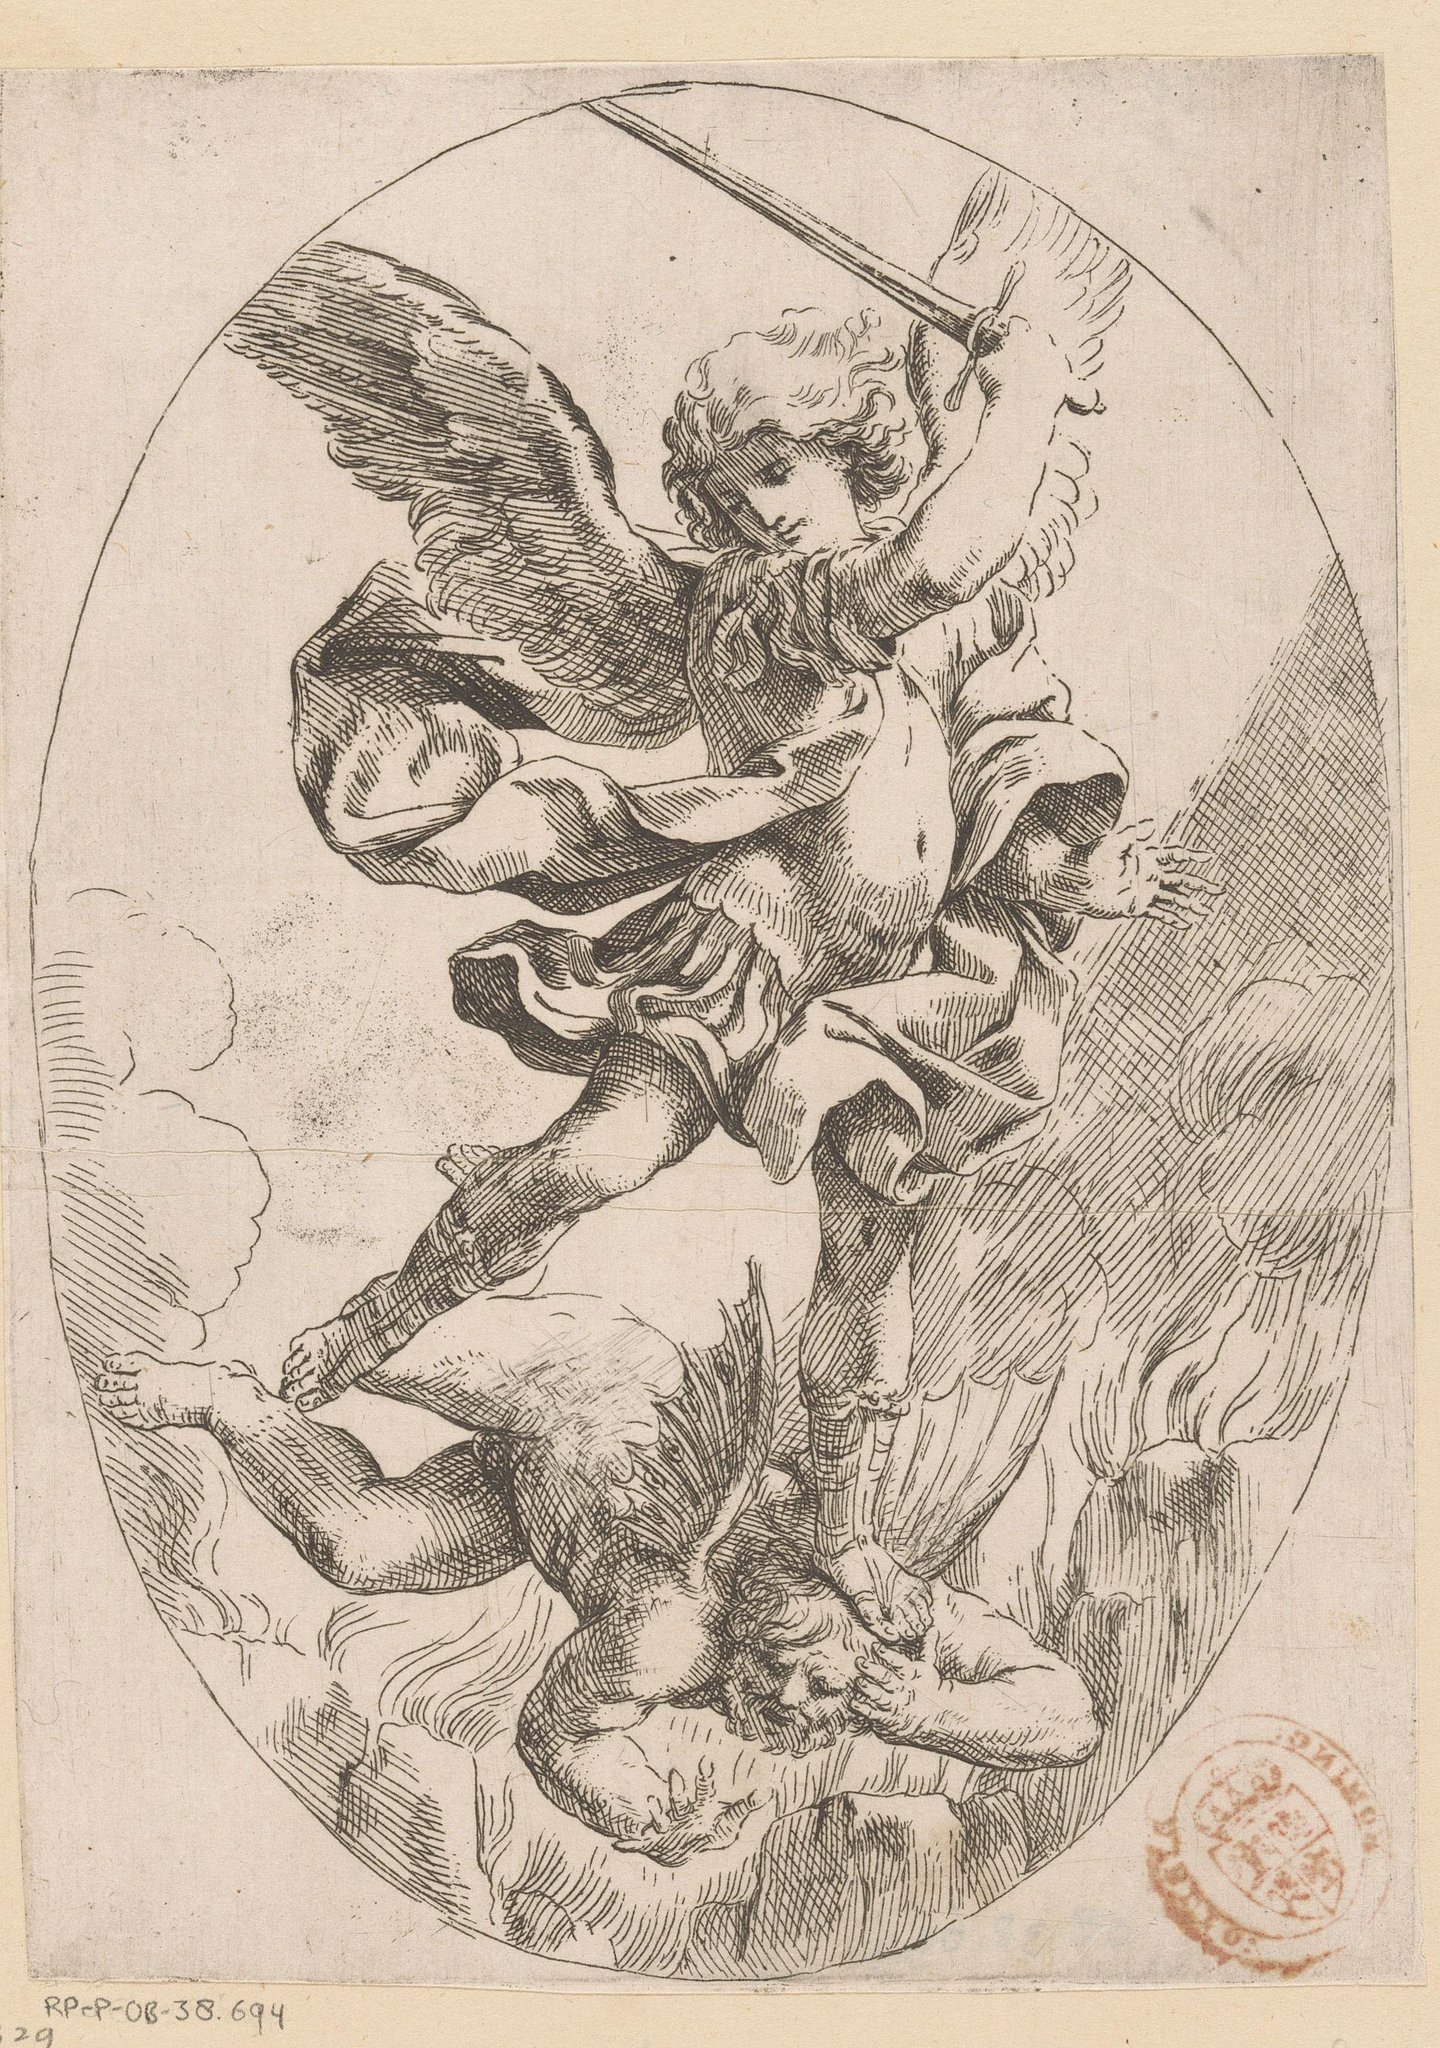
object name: print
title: Aartsengel Michaël in gevecht met de draak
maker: Anonymous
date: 1595-1692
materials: paper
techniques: etching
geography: italy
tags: the archangel michael fighting the dragon (devil, satan)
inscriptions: collector's mark: Lugt 240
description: De aartsengel Michaël vertrapt de draak (de duivel).